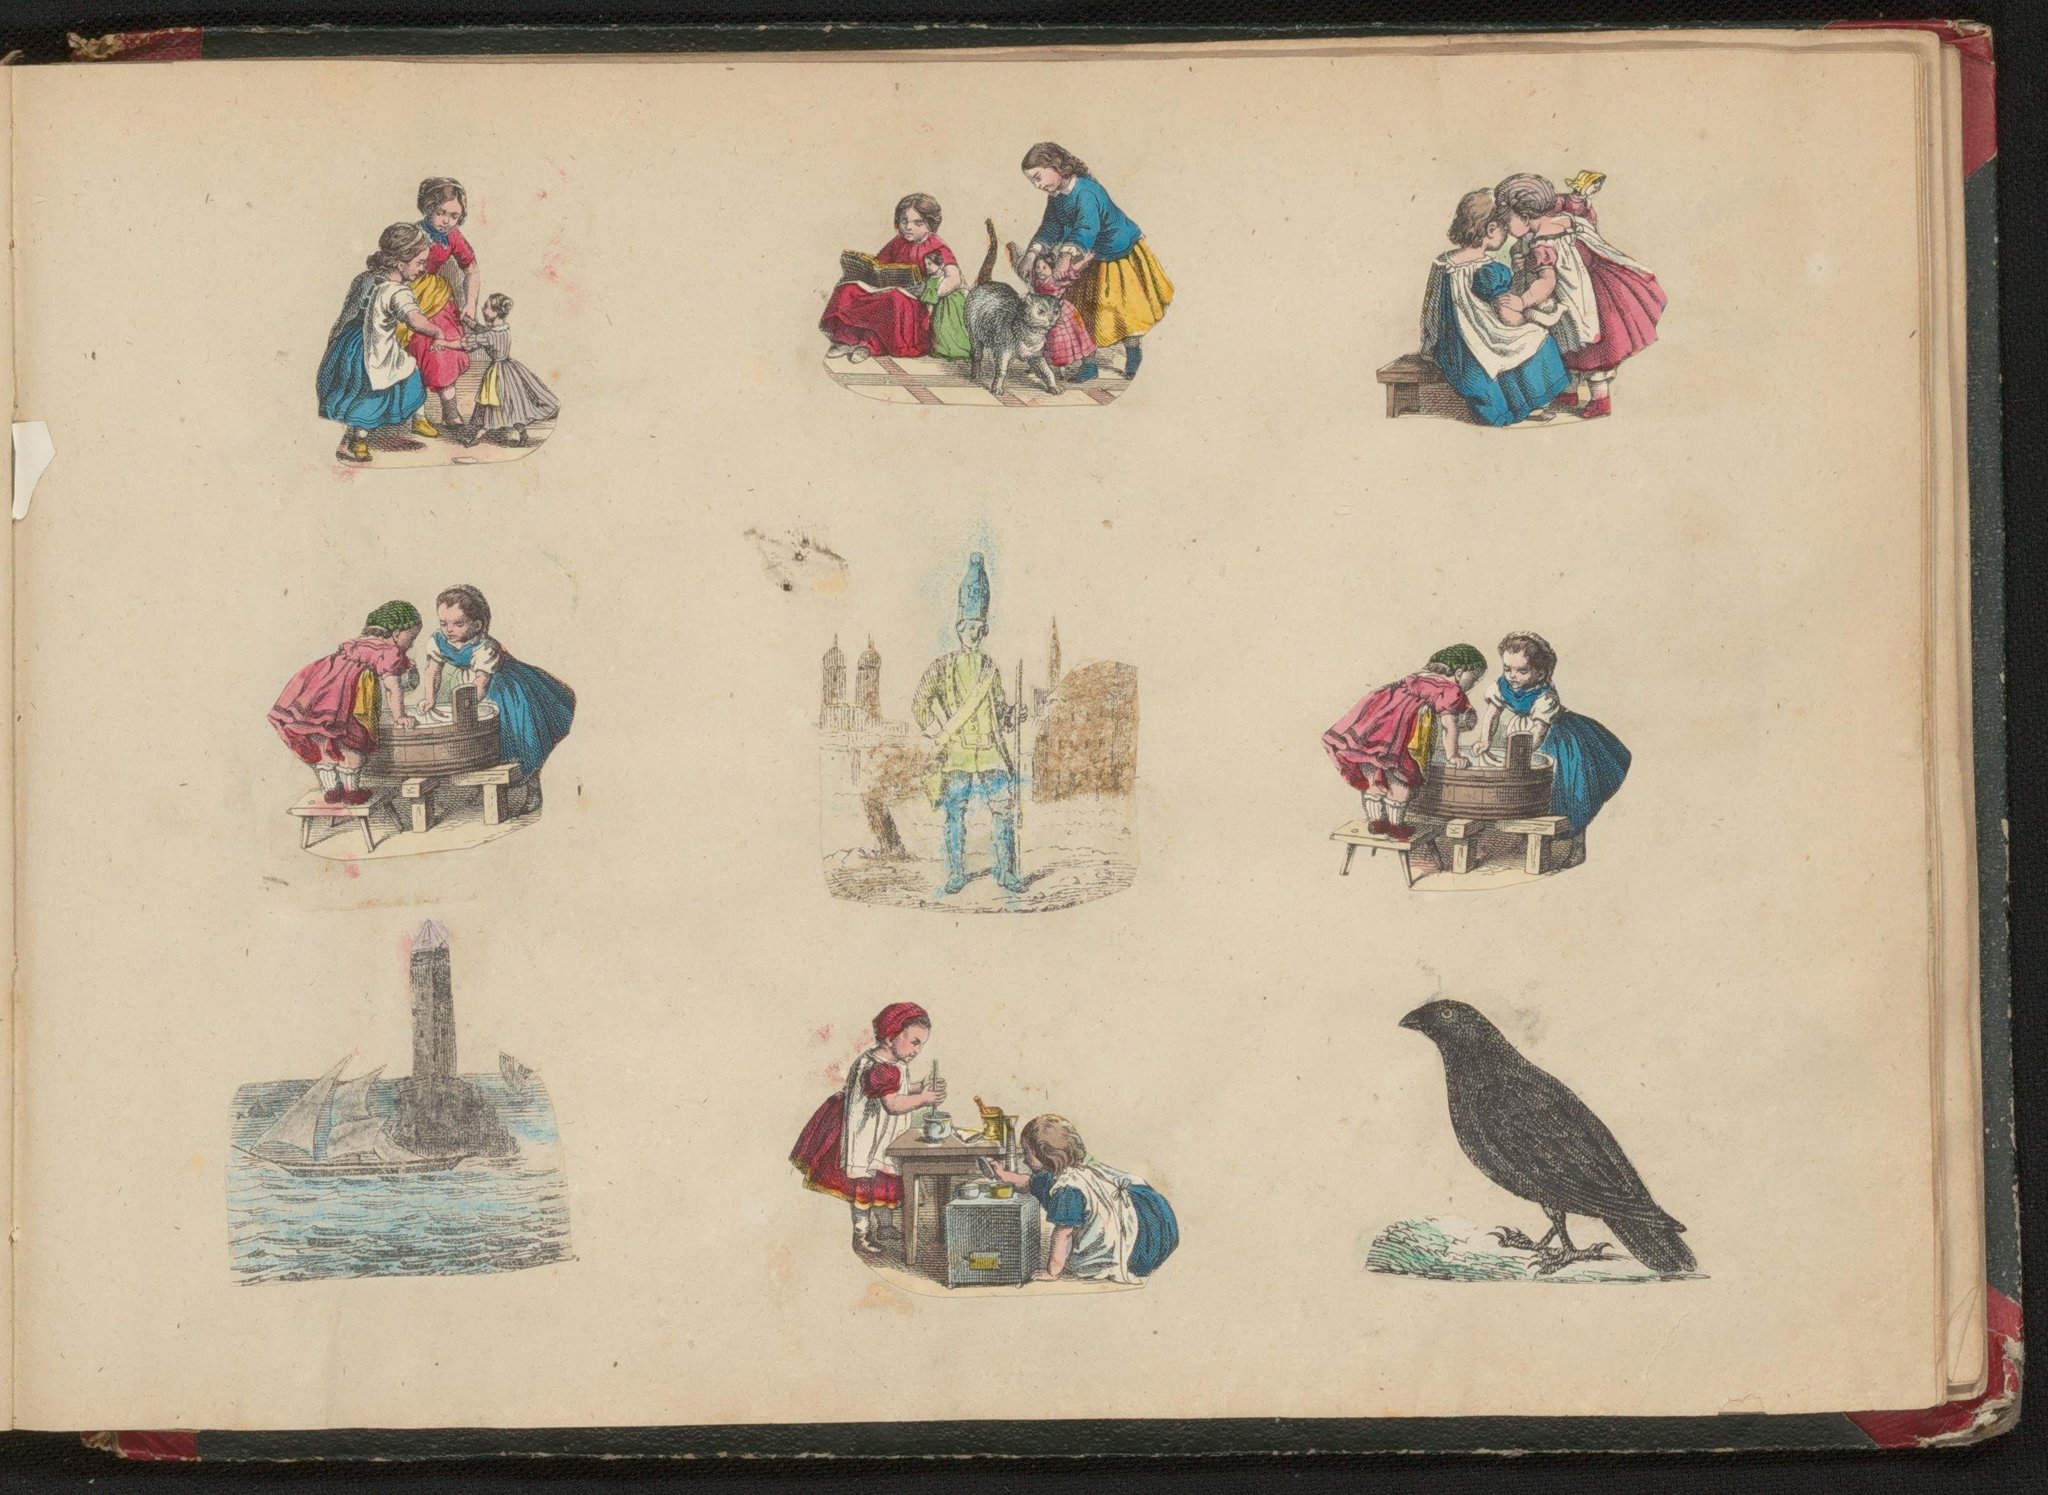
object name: album leaf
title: Albumblad met 9 prentfragmenten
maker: Anonymous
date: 1880-1910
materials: paper, watercolor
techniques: hand coloring, lithograph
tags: children's games and plays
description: Albumblad met 9 ingeplakte uitgeknipte fragmenten van prenten, voornamelijk kinderspel. Onderdeel van het plakboek met 38 bladen gevuld met plakplaatjes, poesieplaatjes en uitgeknipte en ingeplakte fragmenten van prenten. Onderwerpsrubrieken binnen de Atlas Zeden en Gewoonten: Schoone kunsten, Varia.